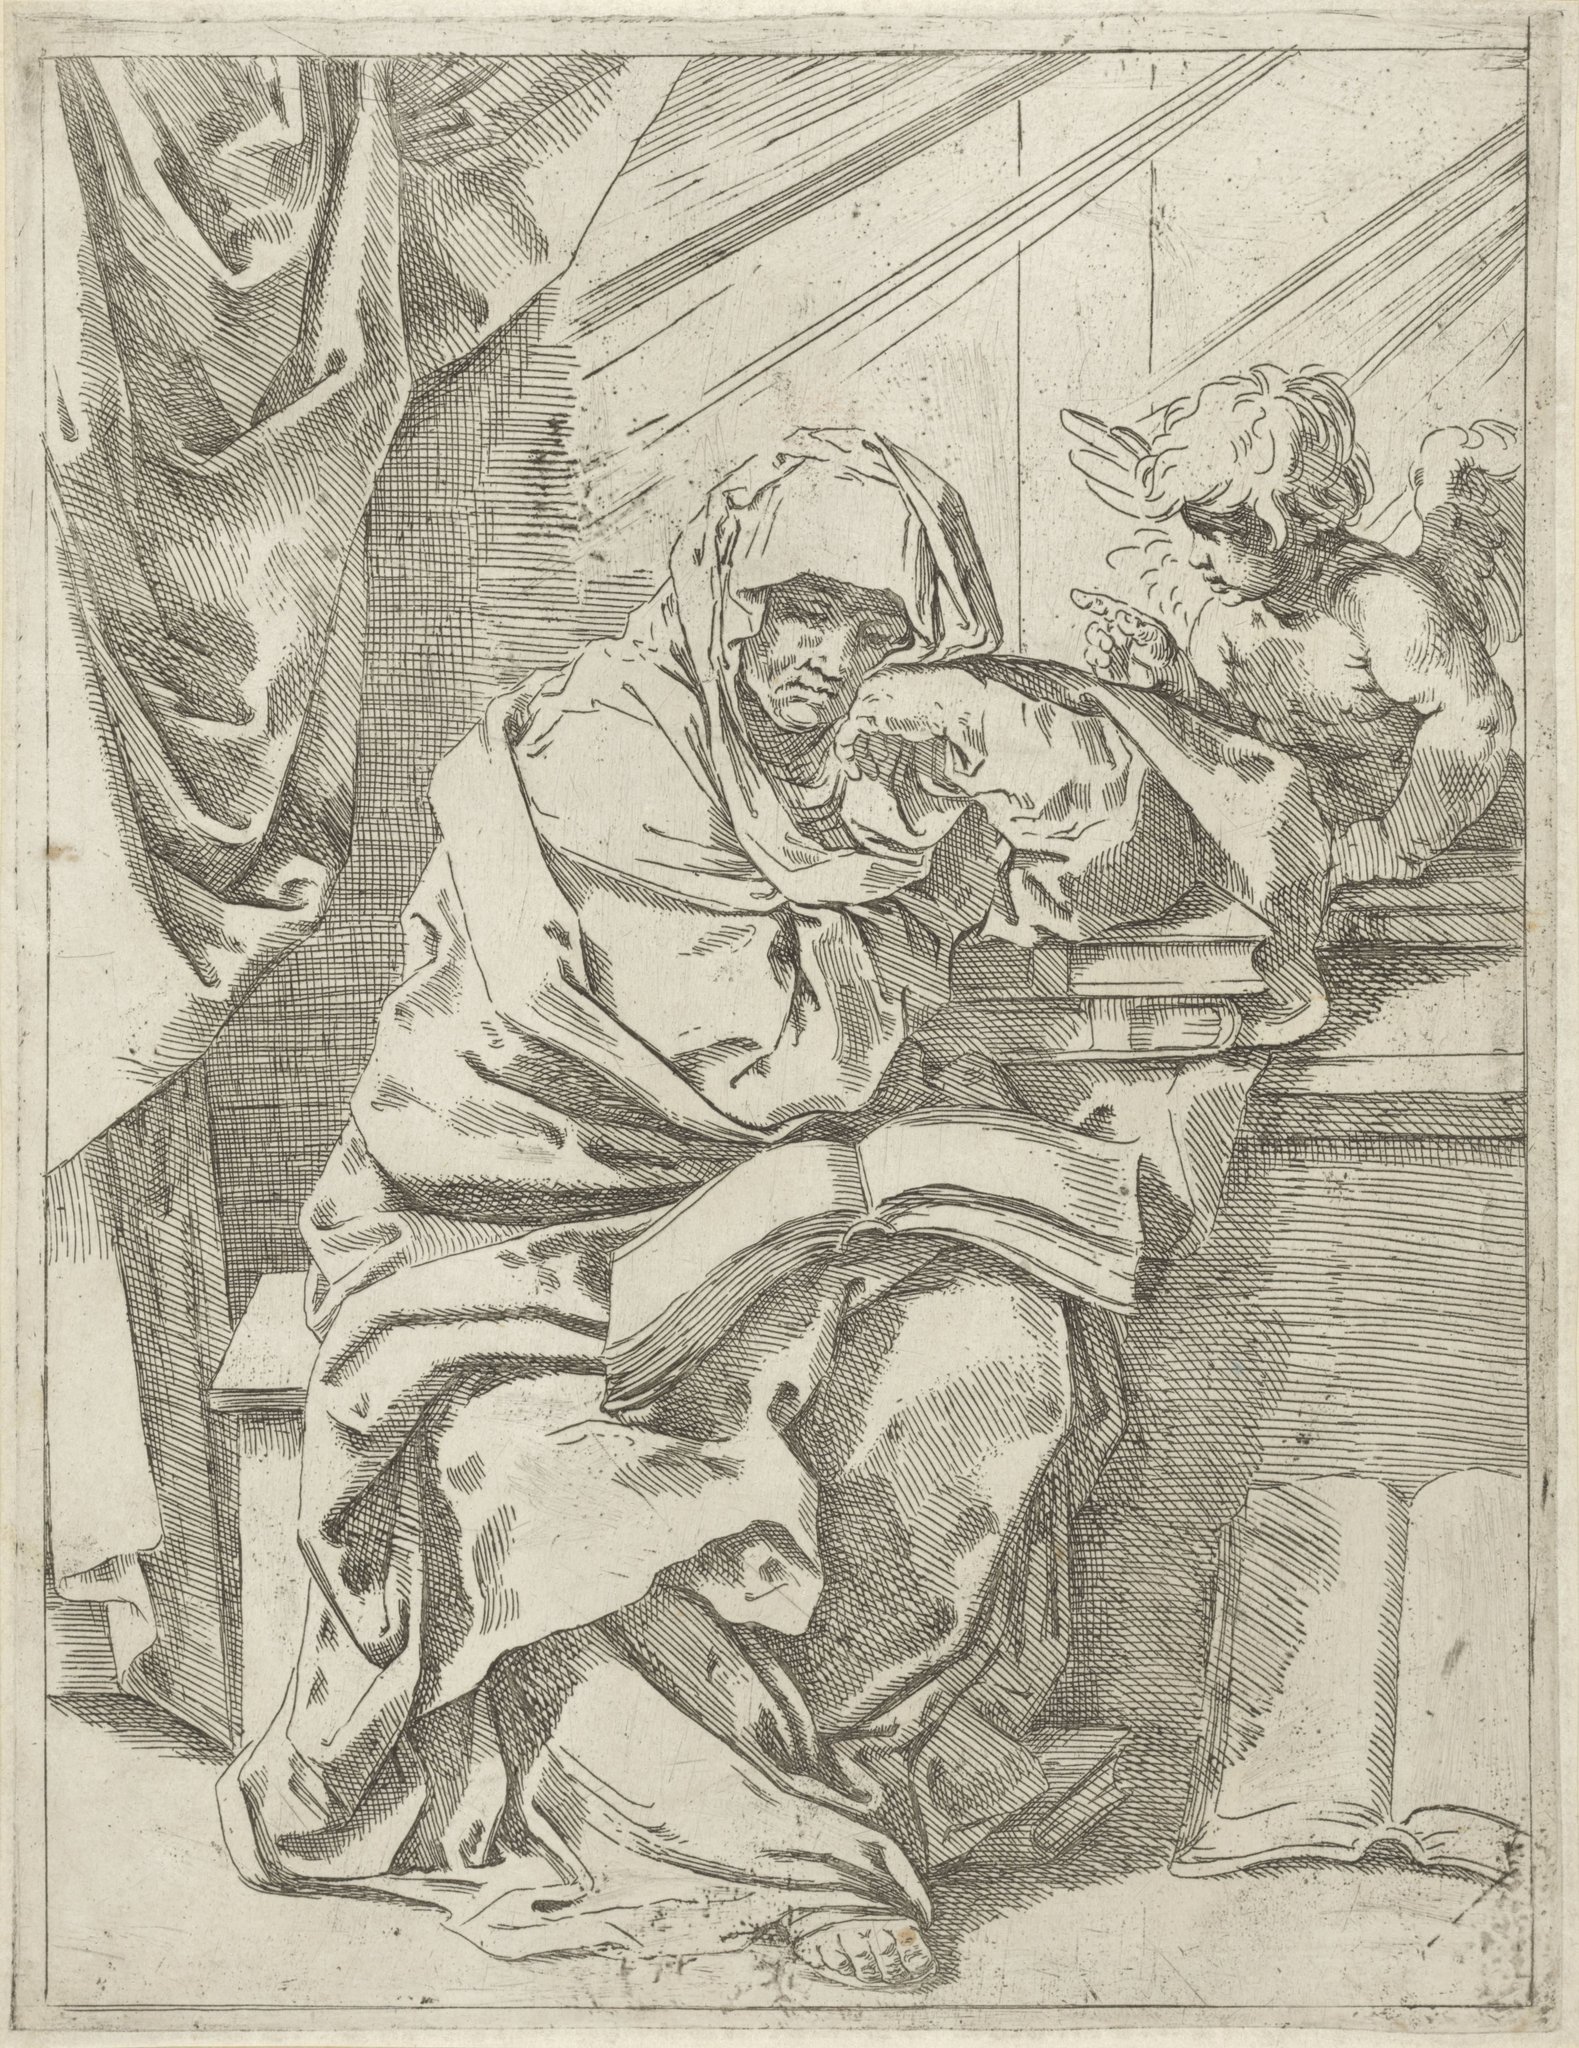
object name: print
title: Lezende Sibille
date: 1622-1691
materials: paper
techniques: etching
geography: italy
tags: reading, sibyls, cupids: 'amores', 'amoretti', 'putti'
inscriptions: collector's mark: Lugt 240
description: Een zittende Sibille met een opengeslagen boek op haar schoot. Ze leunt met haar arm op een stapel boeken. Naast haar zit een putto.